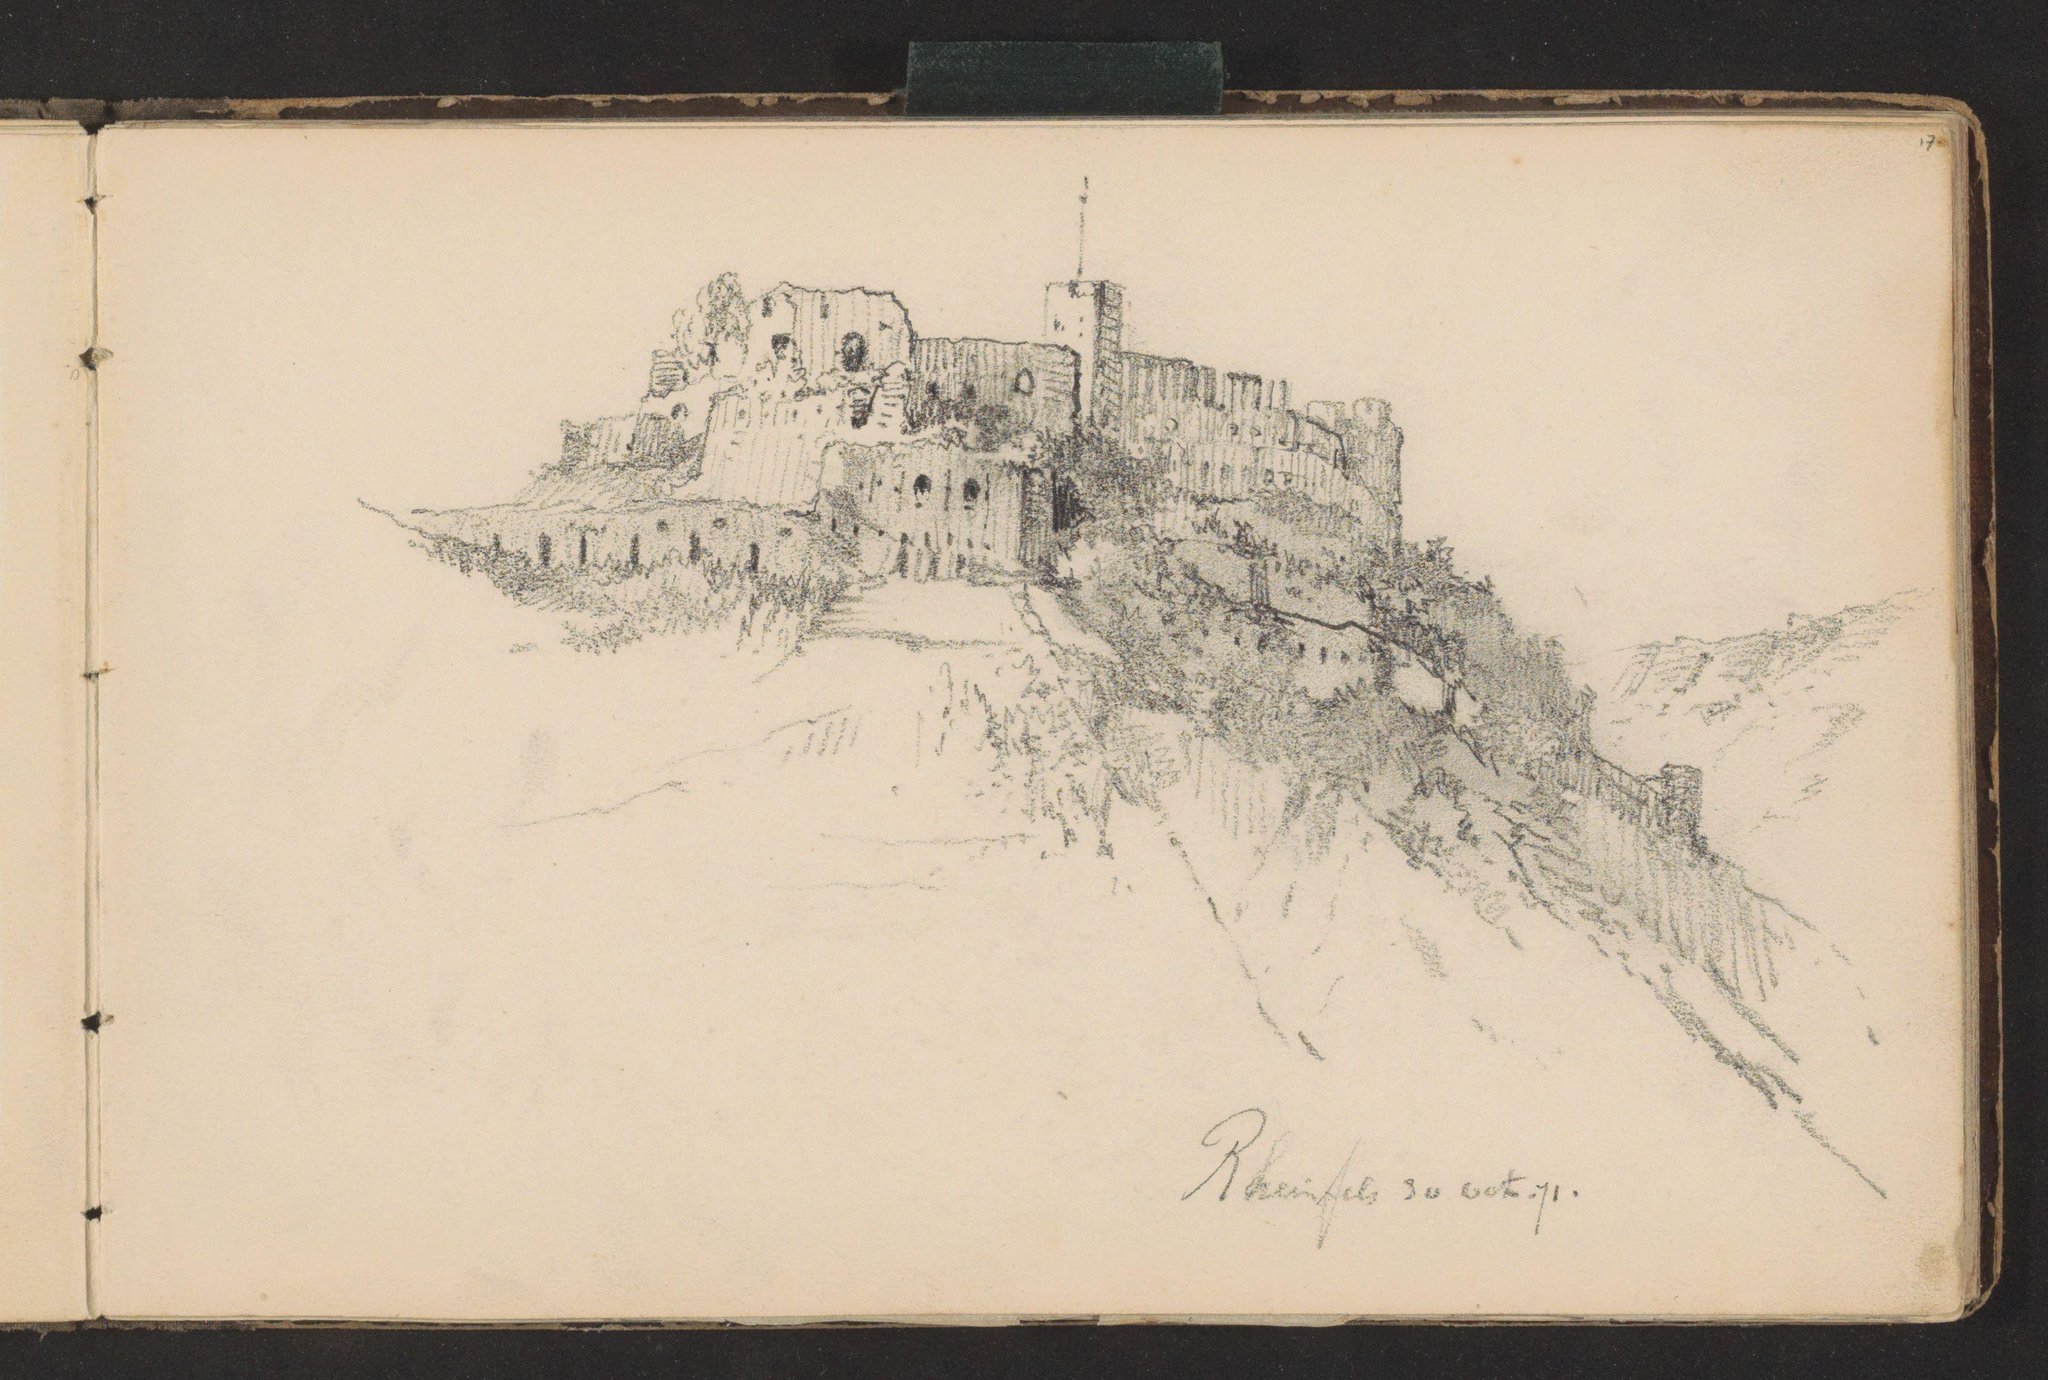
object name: sketchbook leaf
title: Ruïne van Burg Rheinfels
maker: maria vos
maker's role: draughtsman, painter, print maker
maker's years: 1824-1906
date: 1810-1871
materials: paper, pencil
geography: sankt goar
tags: ruin of a dwelling, house, castle, etc.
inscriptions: date and inscription: ‘Rheinfels 30 oct. 71.’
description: Blad 17 recto uit een schetsboek met 45 bladen.